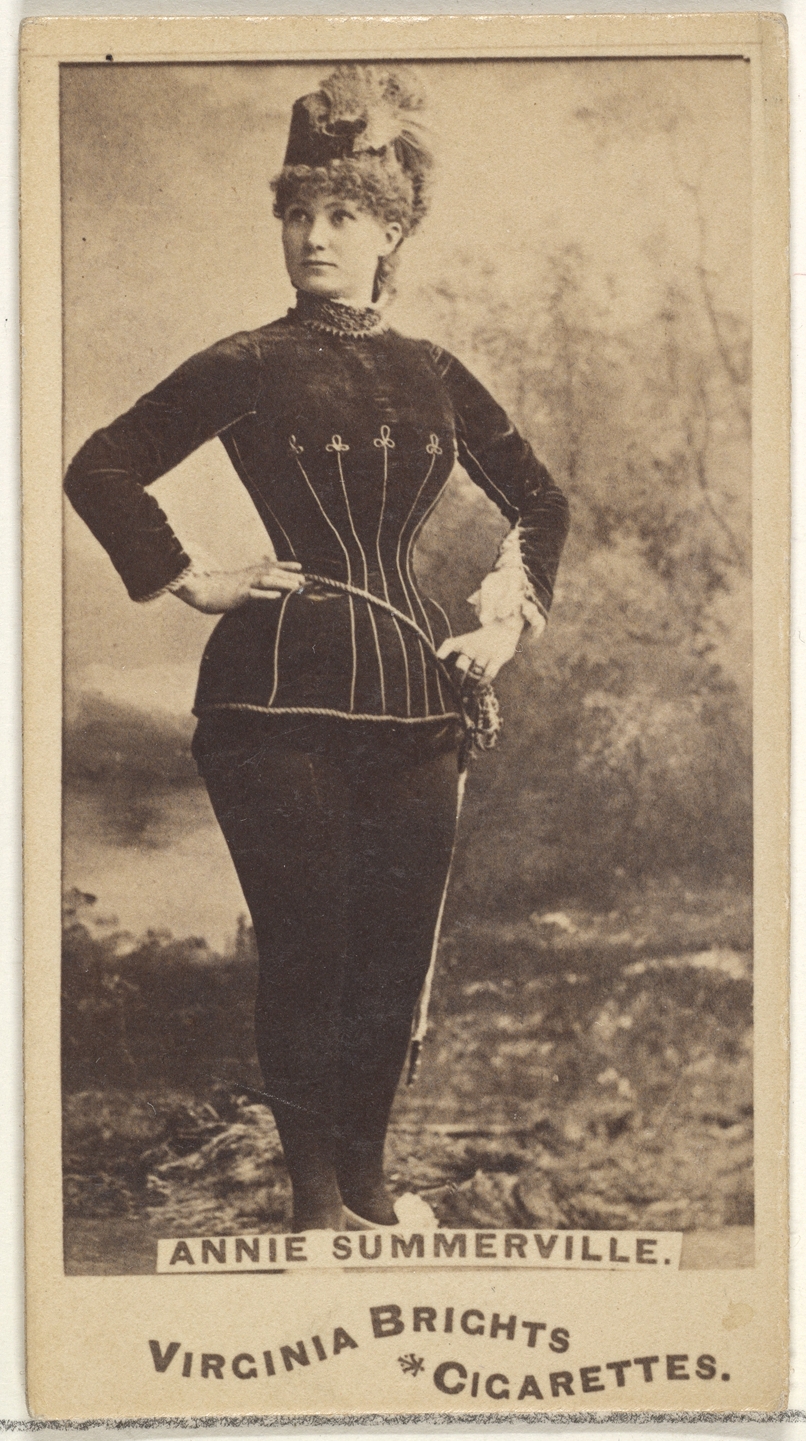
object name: photograph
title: Annie Summerville, from the Actors and Actresses series (N45, Type 1) for Virginia Brights Cigarettes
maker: allen & ginter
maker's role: publisher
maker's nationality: american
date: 1888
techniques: albumen silver print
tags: portraits,women,actresses